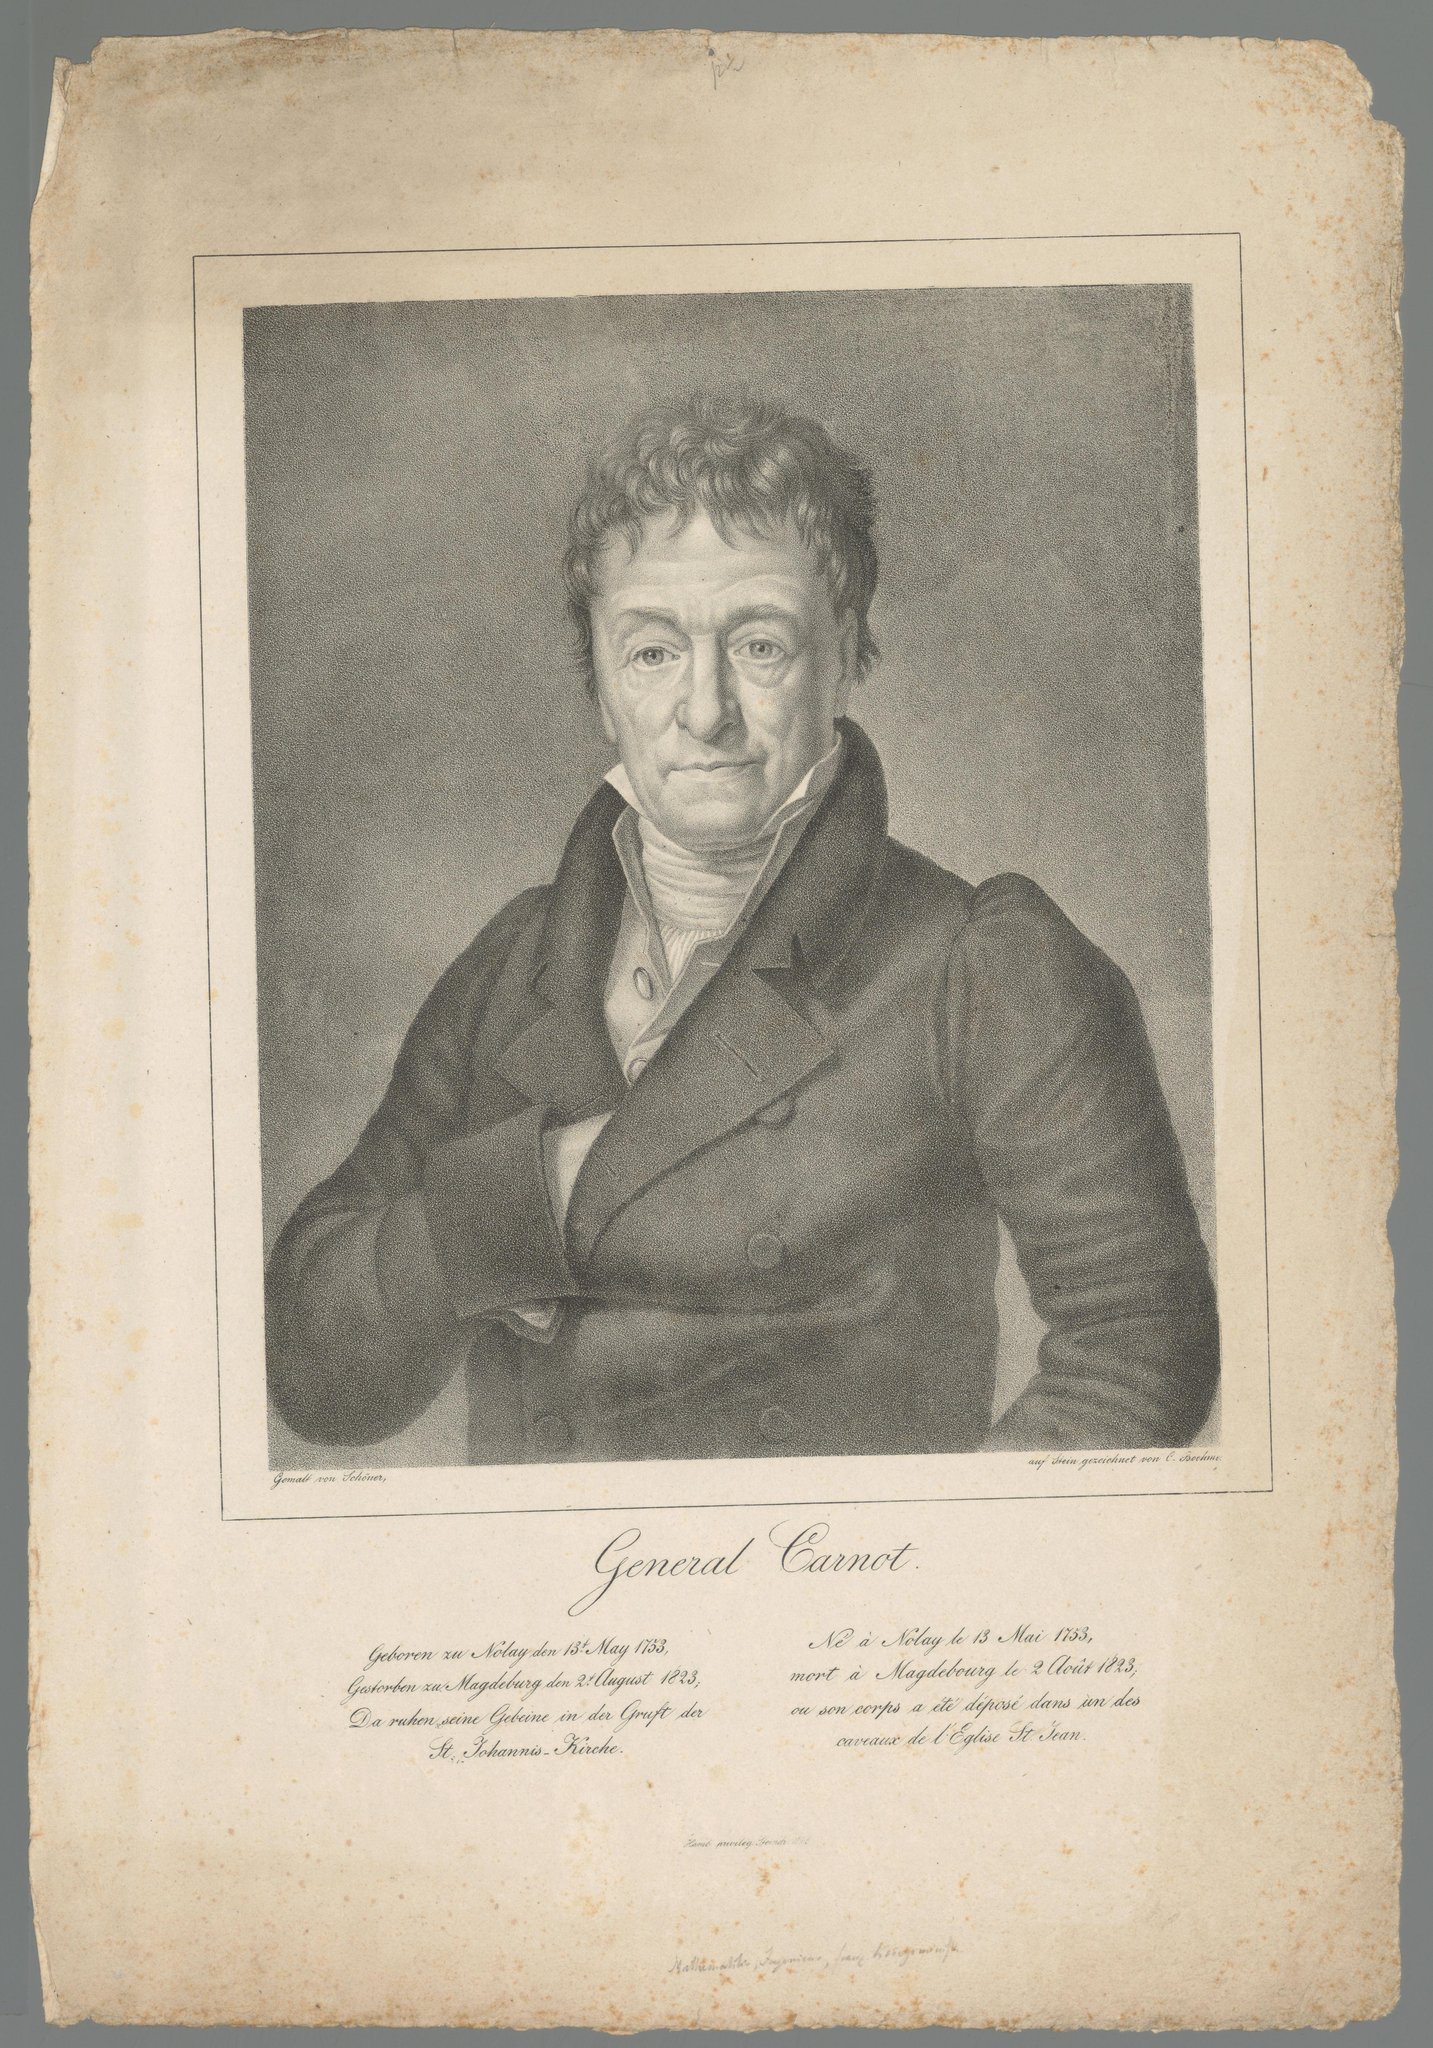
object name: print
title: Portret van Lazare Carnot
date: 1825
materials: paper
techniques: lithograph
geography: hamburg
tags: adult man, historical persons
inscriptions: collector's mark: Lugt 2228